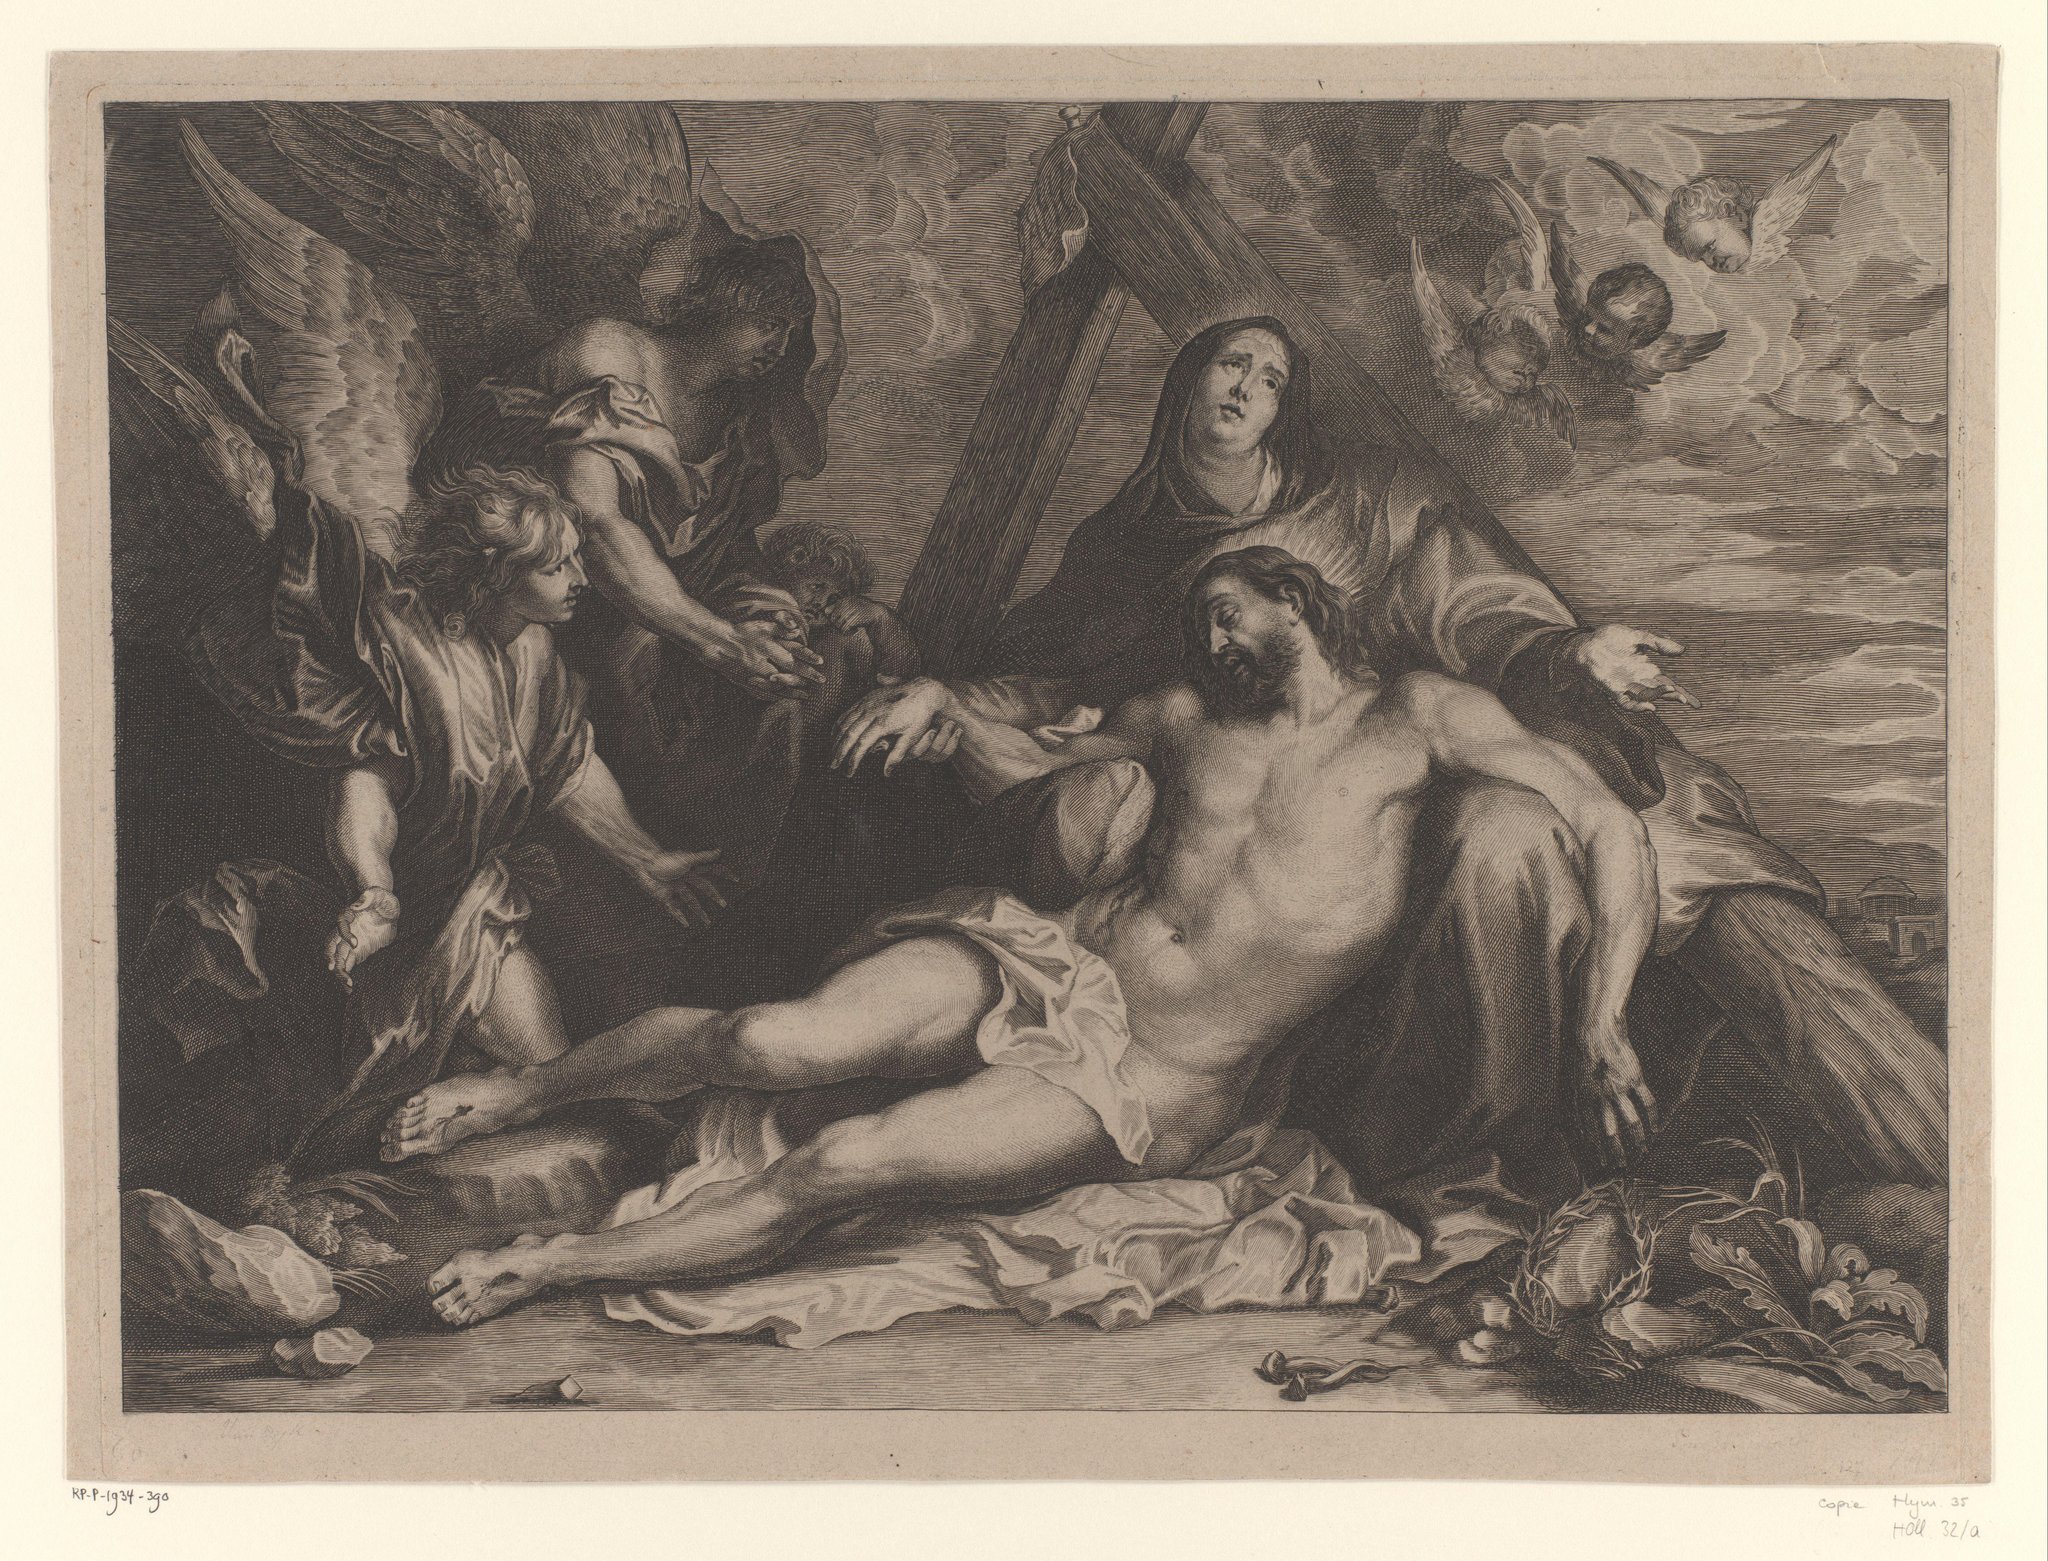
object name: print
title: Bewening van Christus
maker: Anonymous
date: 1634-1684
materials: paper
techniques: engraving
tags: the mourning over the dead christ